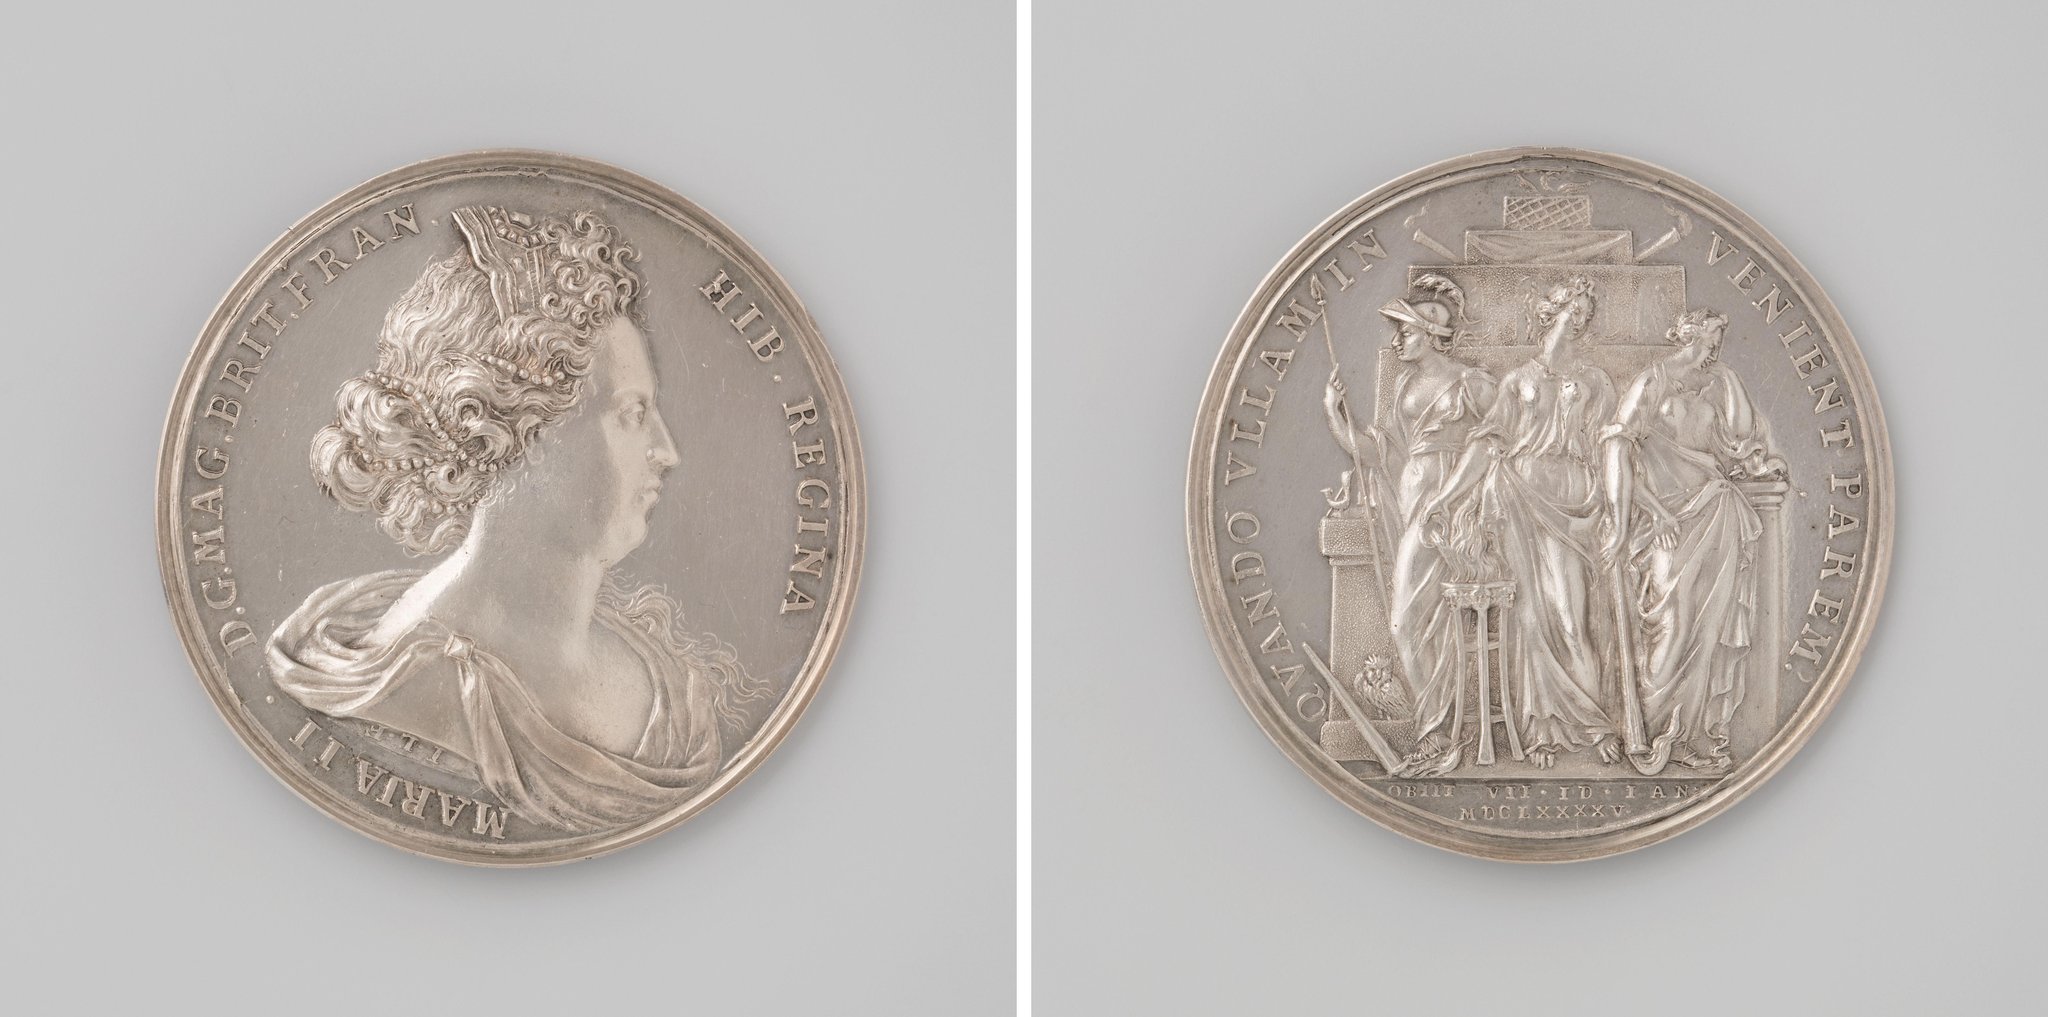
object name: history medal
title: Overlijden van Maria II van Engeland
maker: jan luder (i)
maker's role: medailleur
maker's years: 1648-1719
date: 1695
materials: silver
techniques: striking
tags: london, maria ii stuart (koningin van engeland, schotland en ierland)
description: Zilveren penning. Voorzijde: borststuk vrouw met kroon binnen omschrift. Keerzijde: Wijsheid, Godvruchtheid en Standvastigheid staande voor een lijkstatie binnen omschrift; afsnede: opschrift.